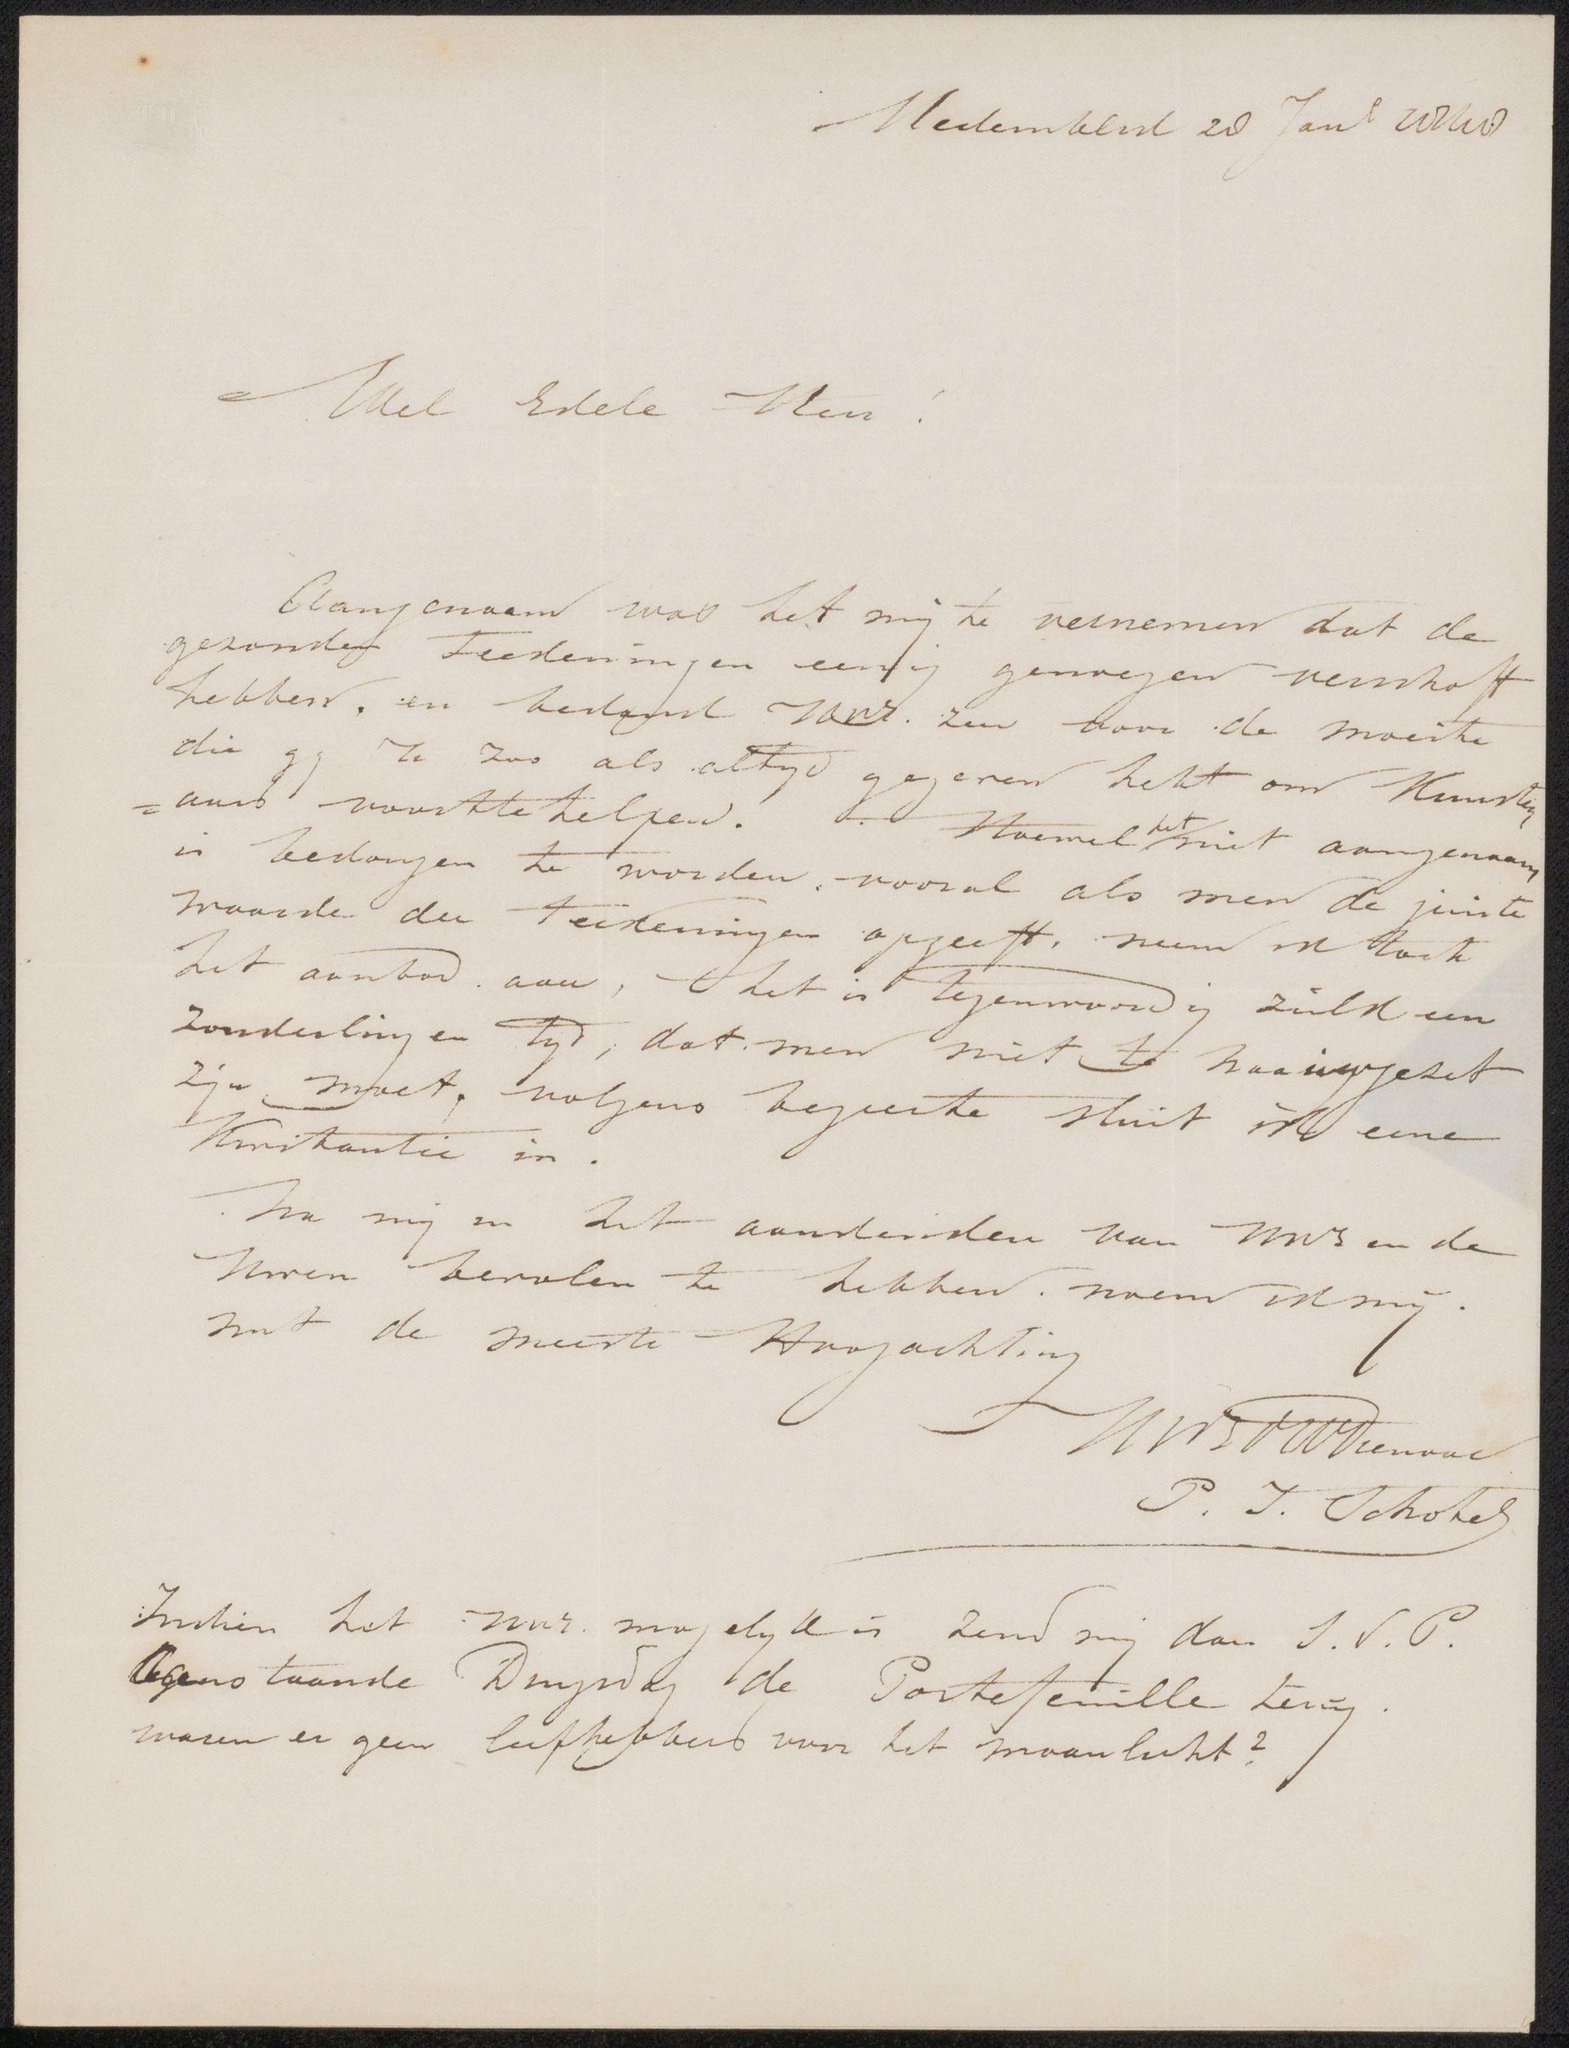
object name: letter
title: Brief aan A.B. Verpoorten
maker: petrus johannes schotel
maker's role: draughtsman, painter, print maker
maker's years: 1808-1865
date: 1848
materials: ink, paper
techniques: pen, writing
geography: medemblik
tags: art trade, art shop, drawing